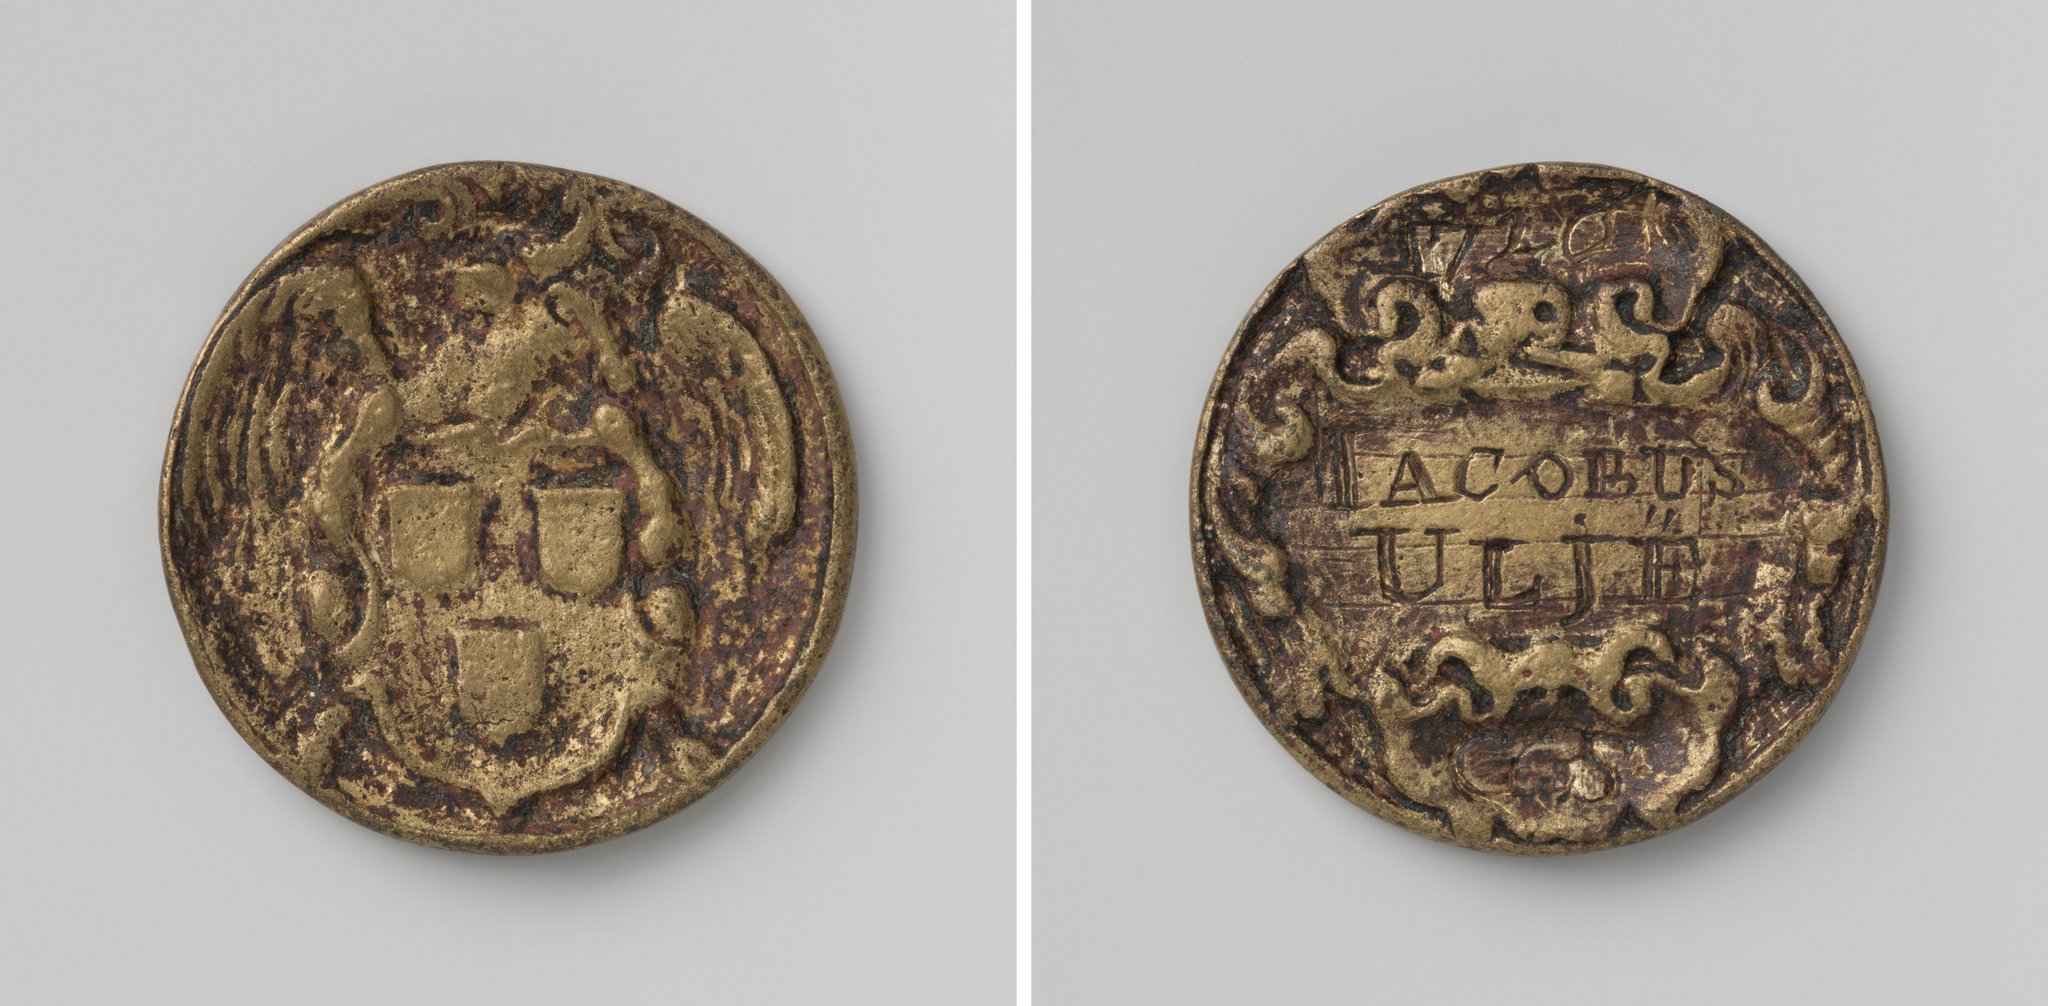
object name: medal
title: St. Lucasgilde van Amsterdam, gildepenning van Jacobus Ulje, glazenmaker en schilder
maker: Anonymous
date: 1716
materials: brass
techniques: casting, engraving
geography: amsterdam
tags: amsterdam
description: Messing penning. Voorzijde: gevleugelde os houdt Lucasschild in zijn poten. Keerzijde: cartouche met opschrift onder doodshoofd en beenderen, en cartouche met jaartal, boven cartouche met letters G en S